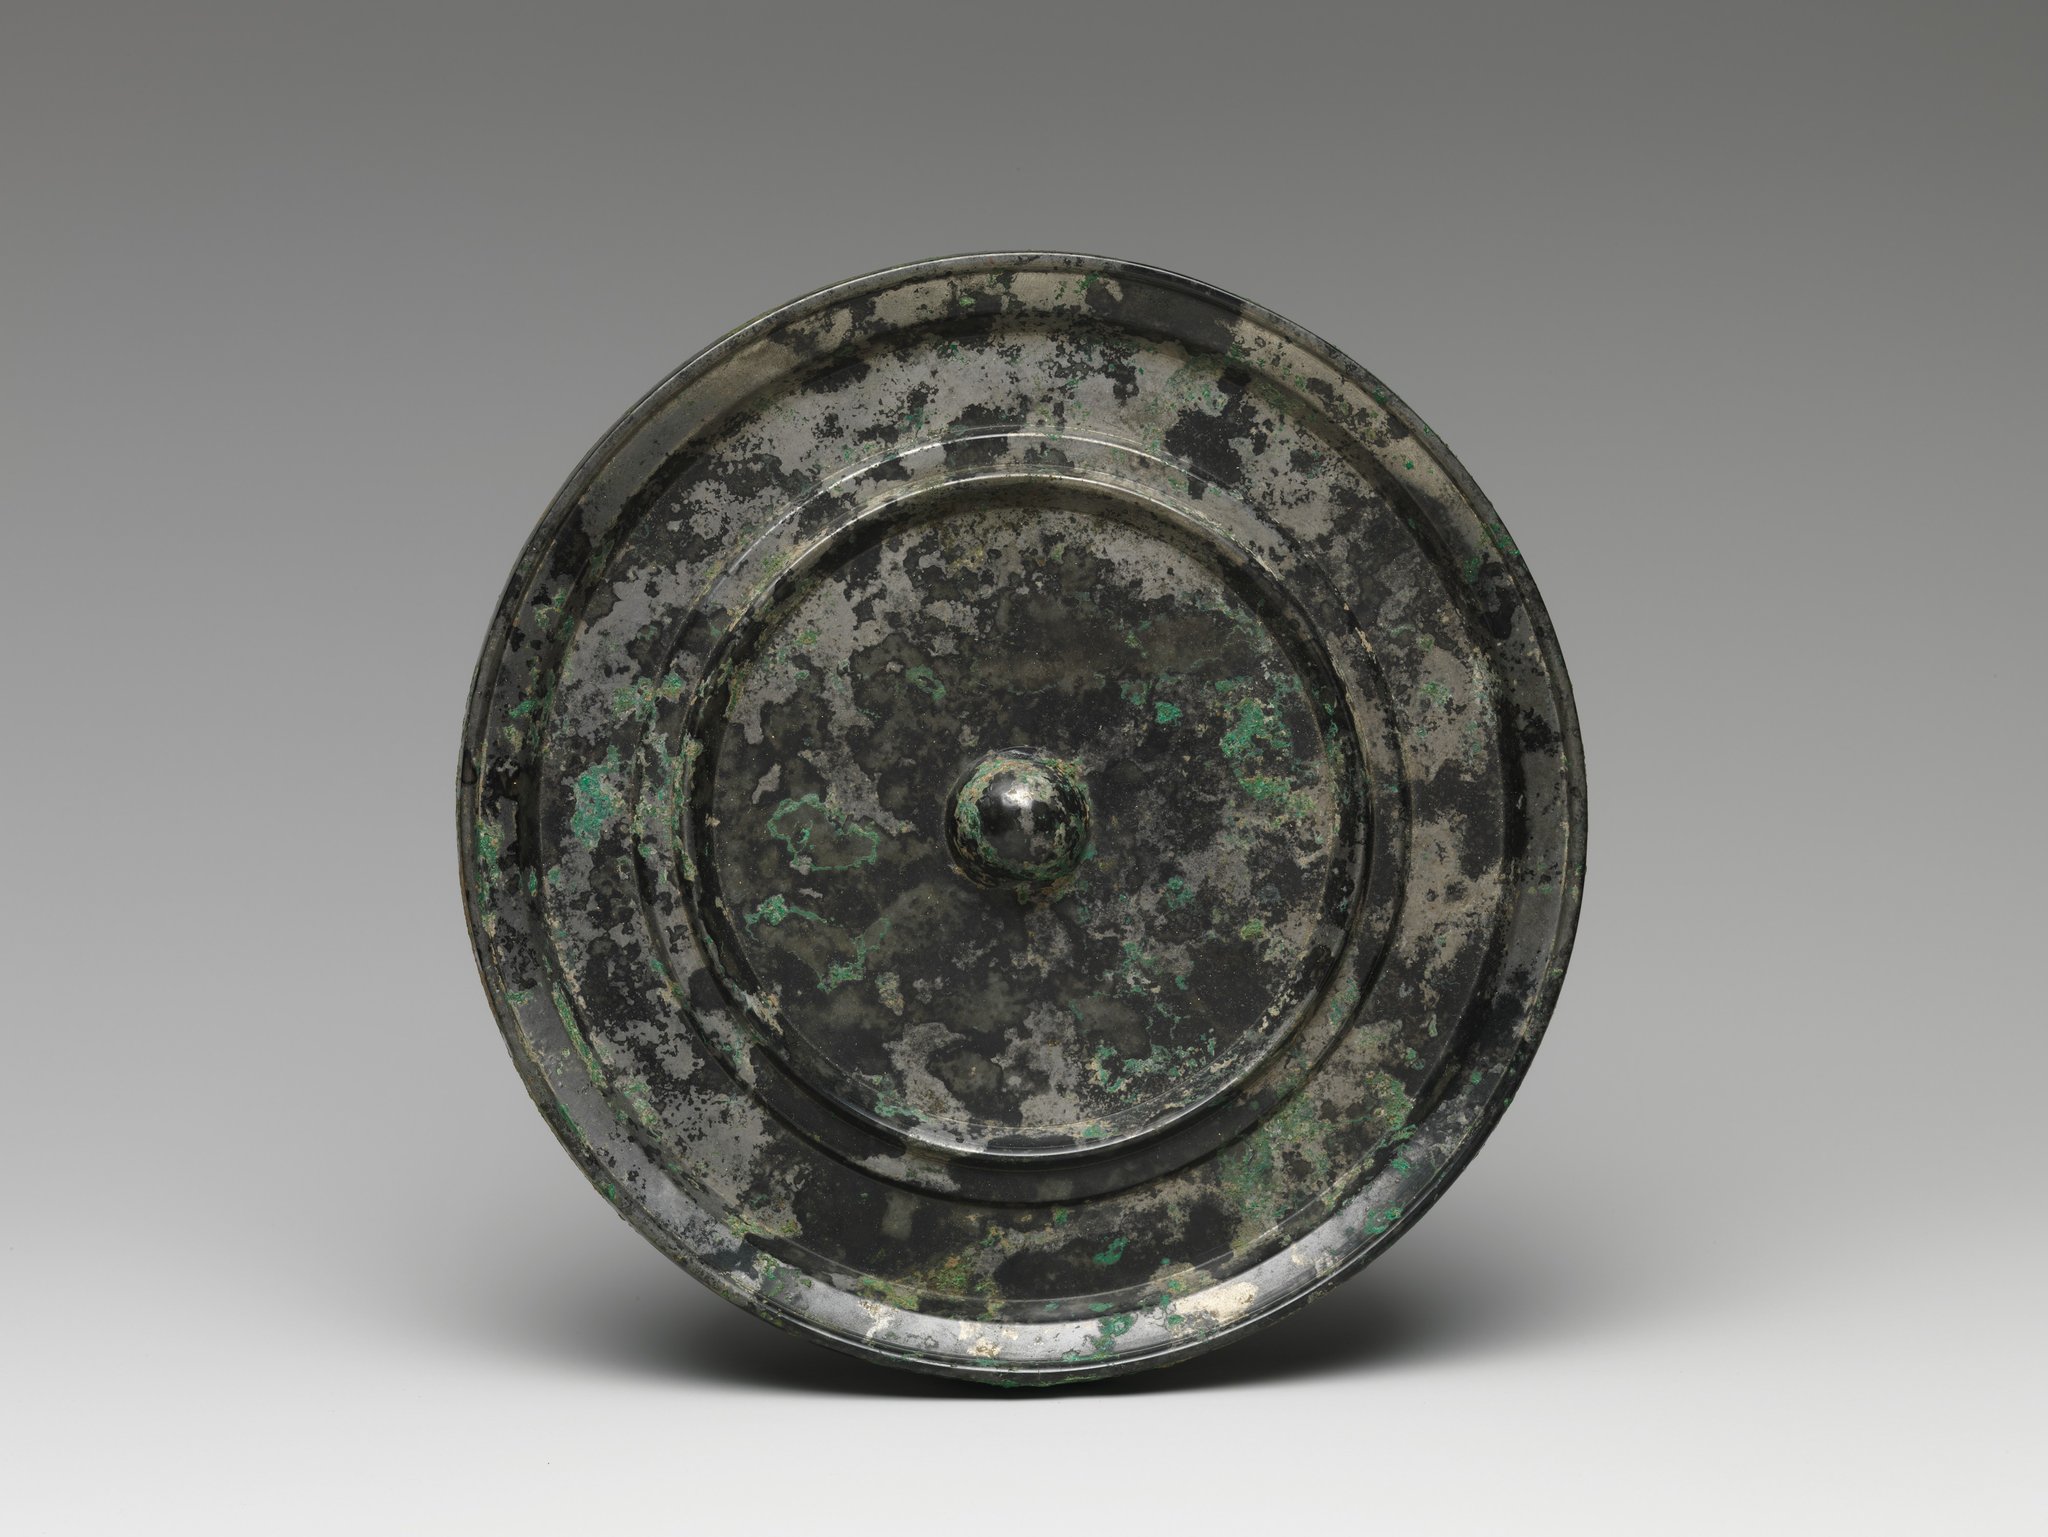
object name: mirror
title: Mirror with design of concentric circles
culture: chinese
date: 701-800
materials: bronze